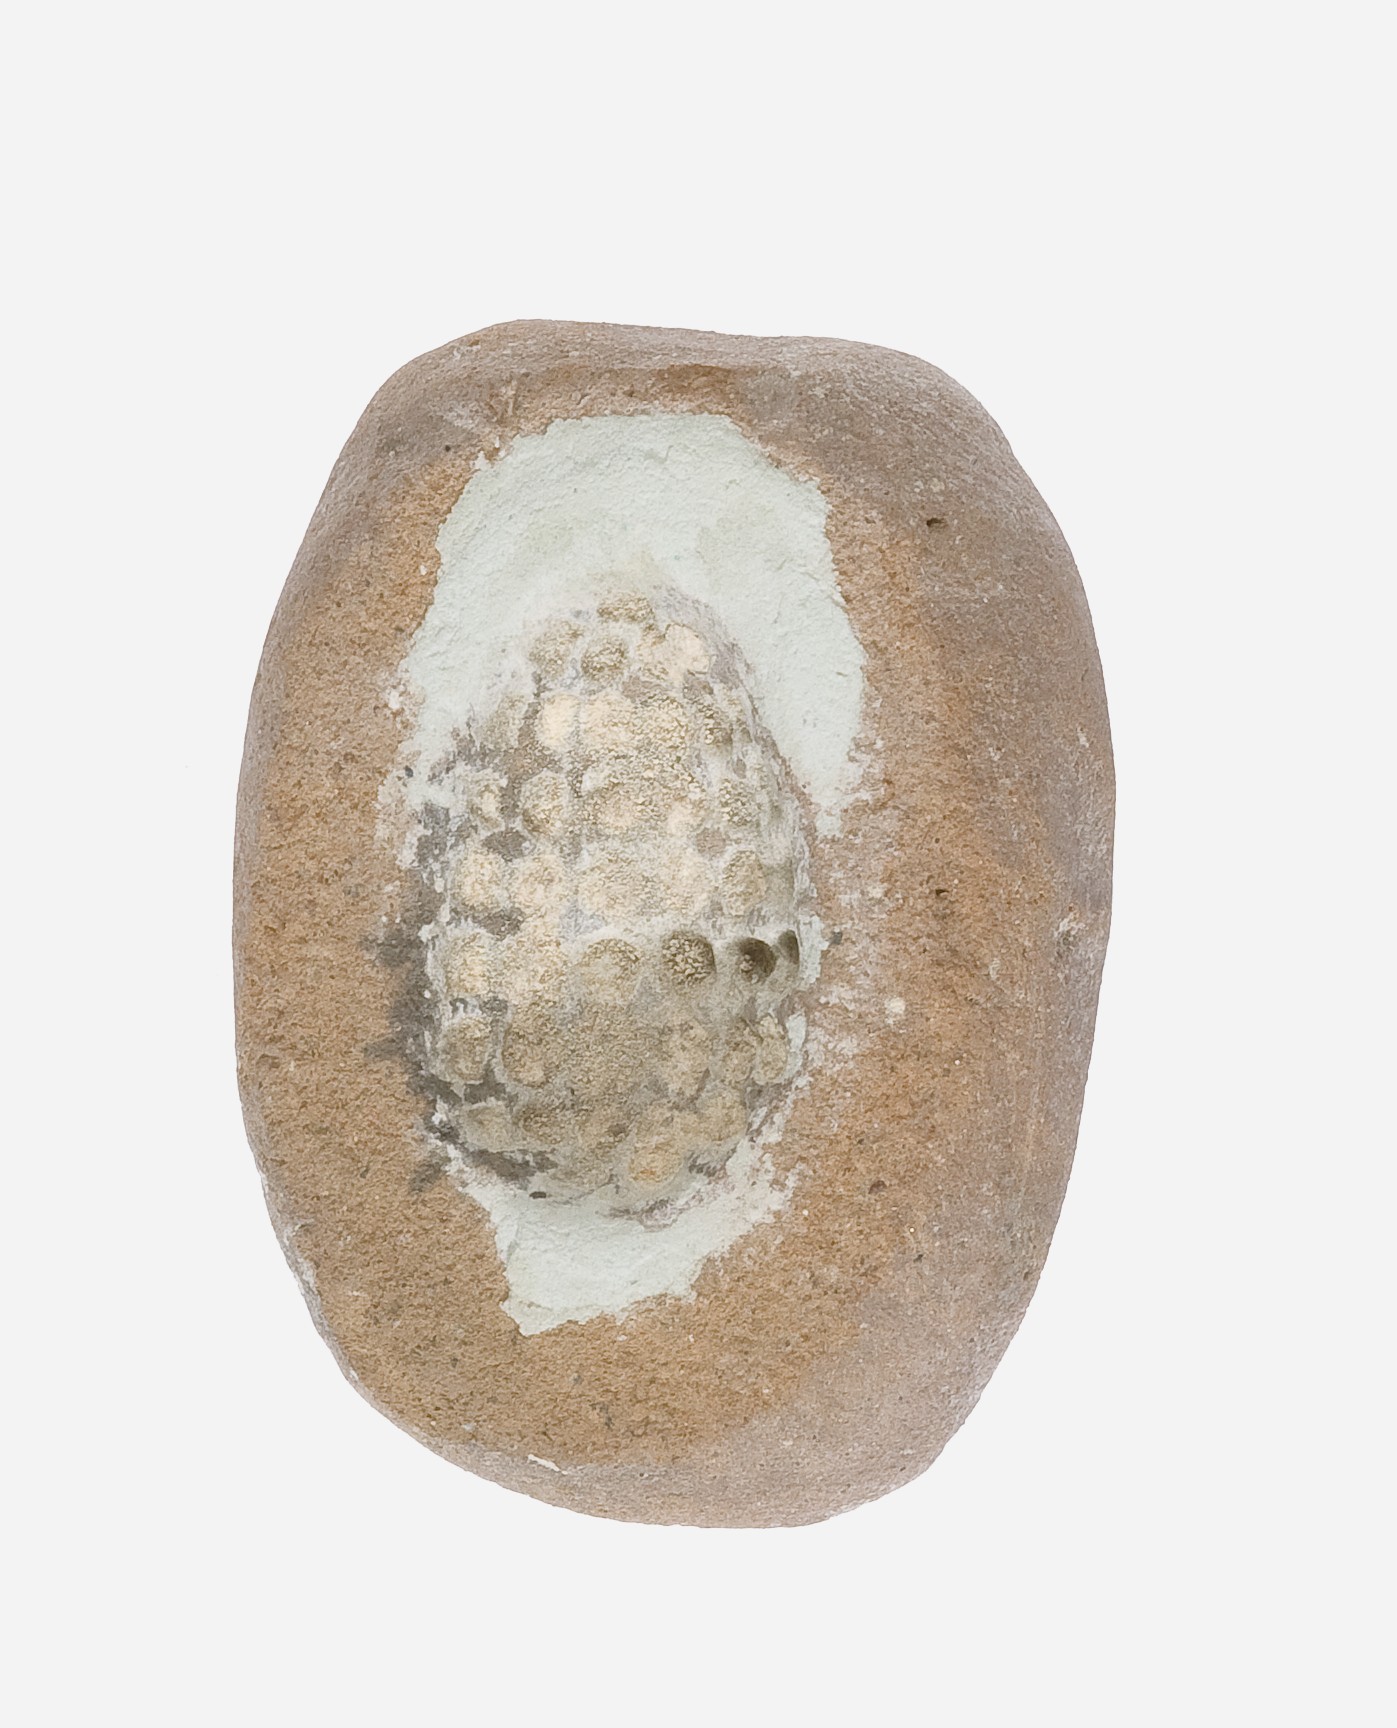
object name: mold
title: Mold: Grapes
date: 1390-1352 BCE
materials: pottery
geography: egypt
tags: grapes